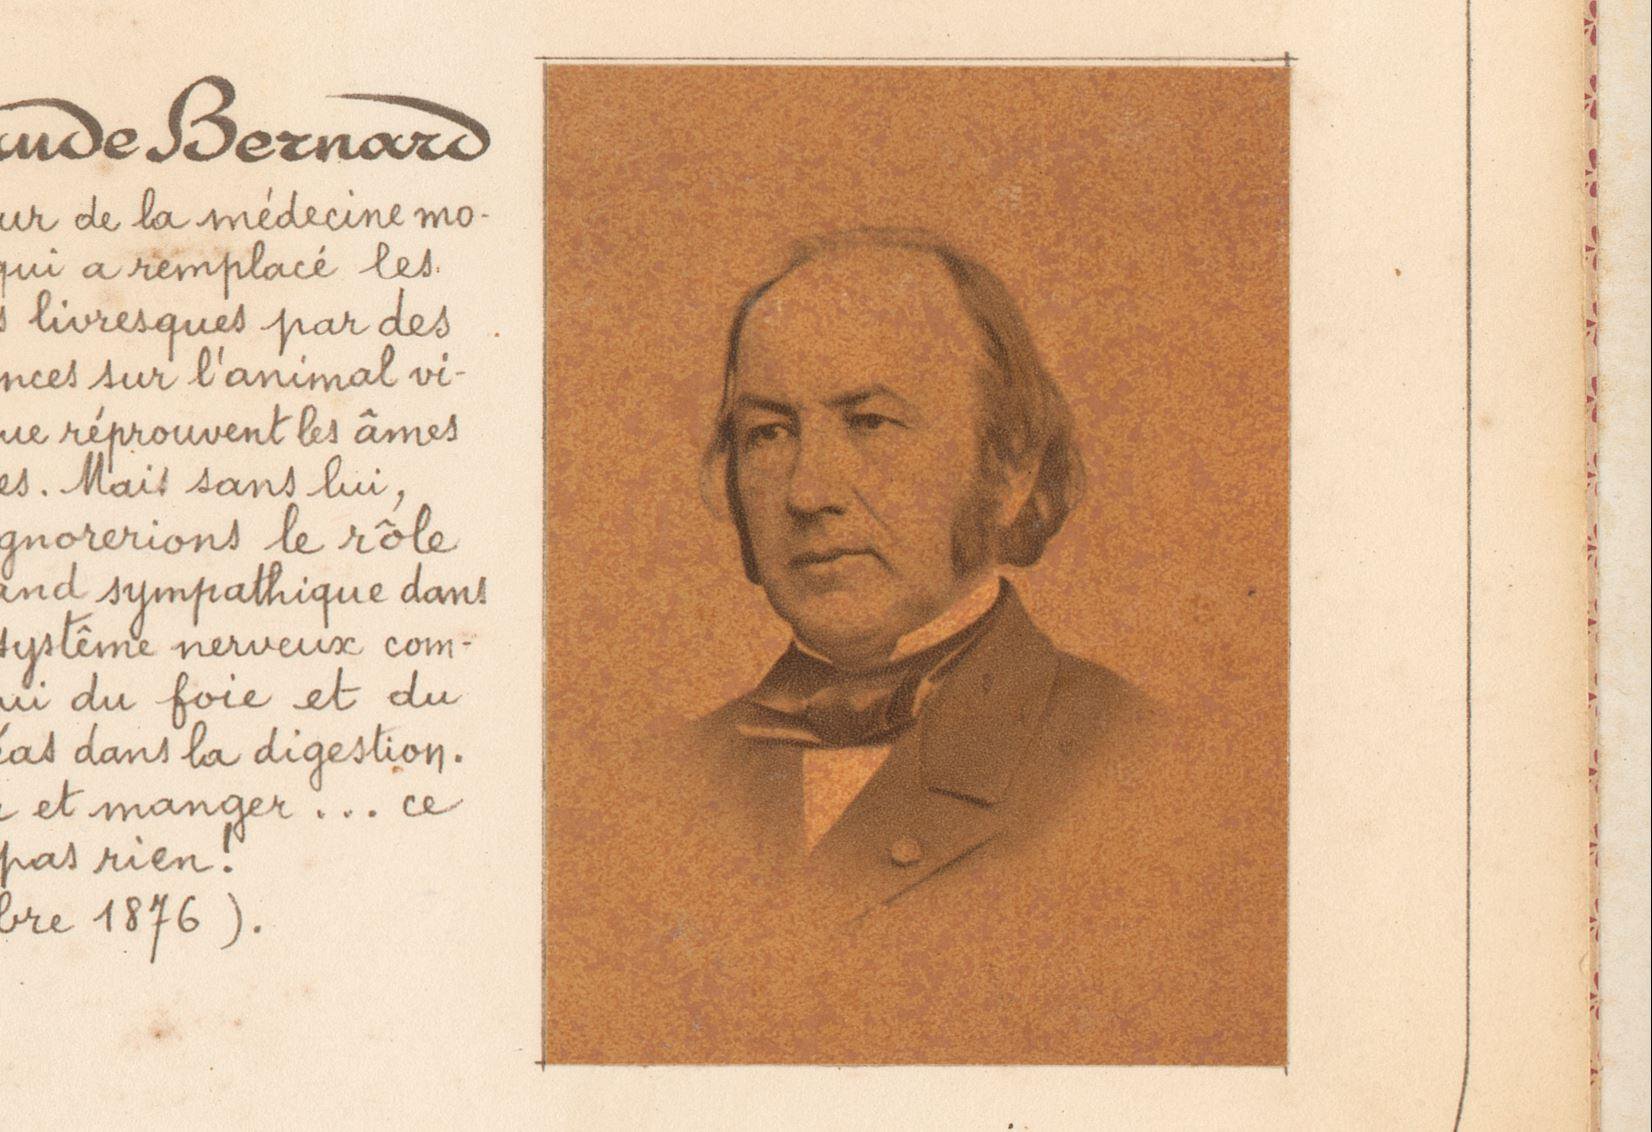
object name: photomechanical print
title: Claude Bernard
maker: Anonymous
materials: paper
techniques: rotogravure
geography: france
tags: historical persons, physician, doctor, france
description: Deze prent maakt deel uit van een album.